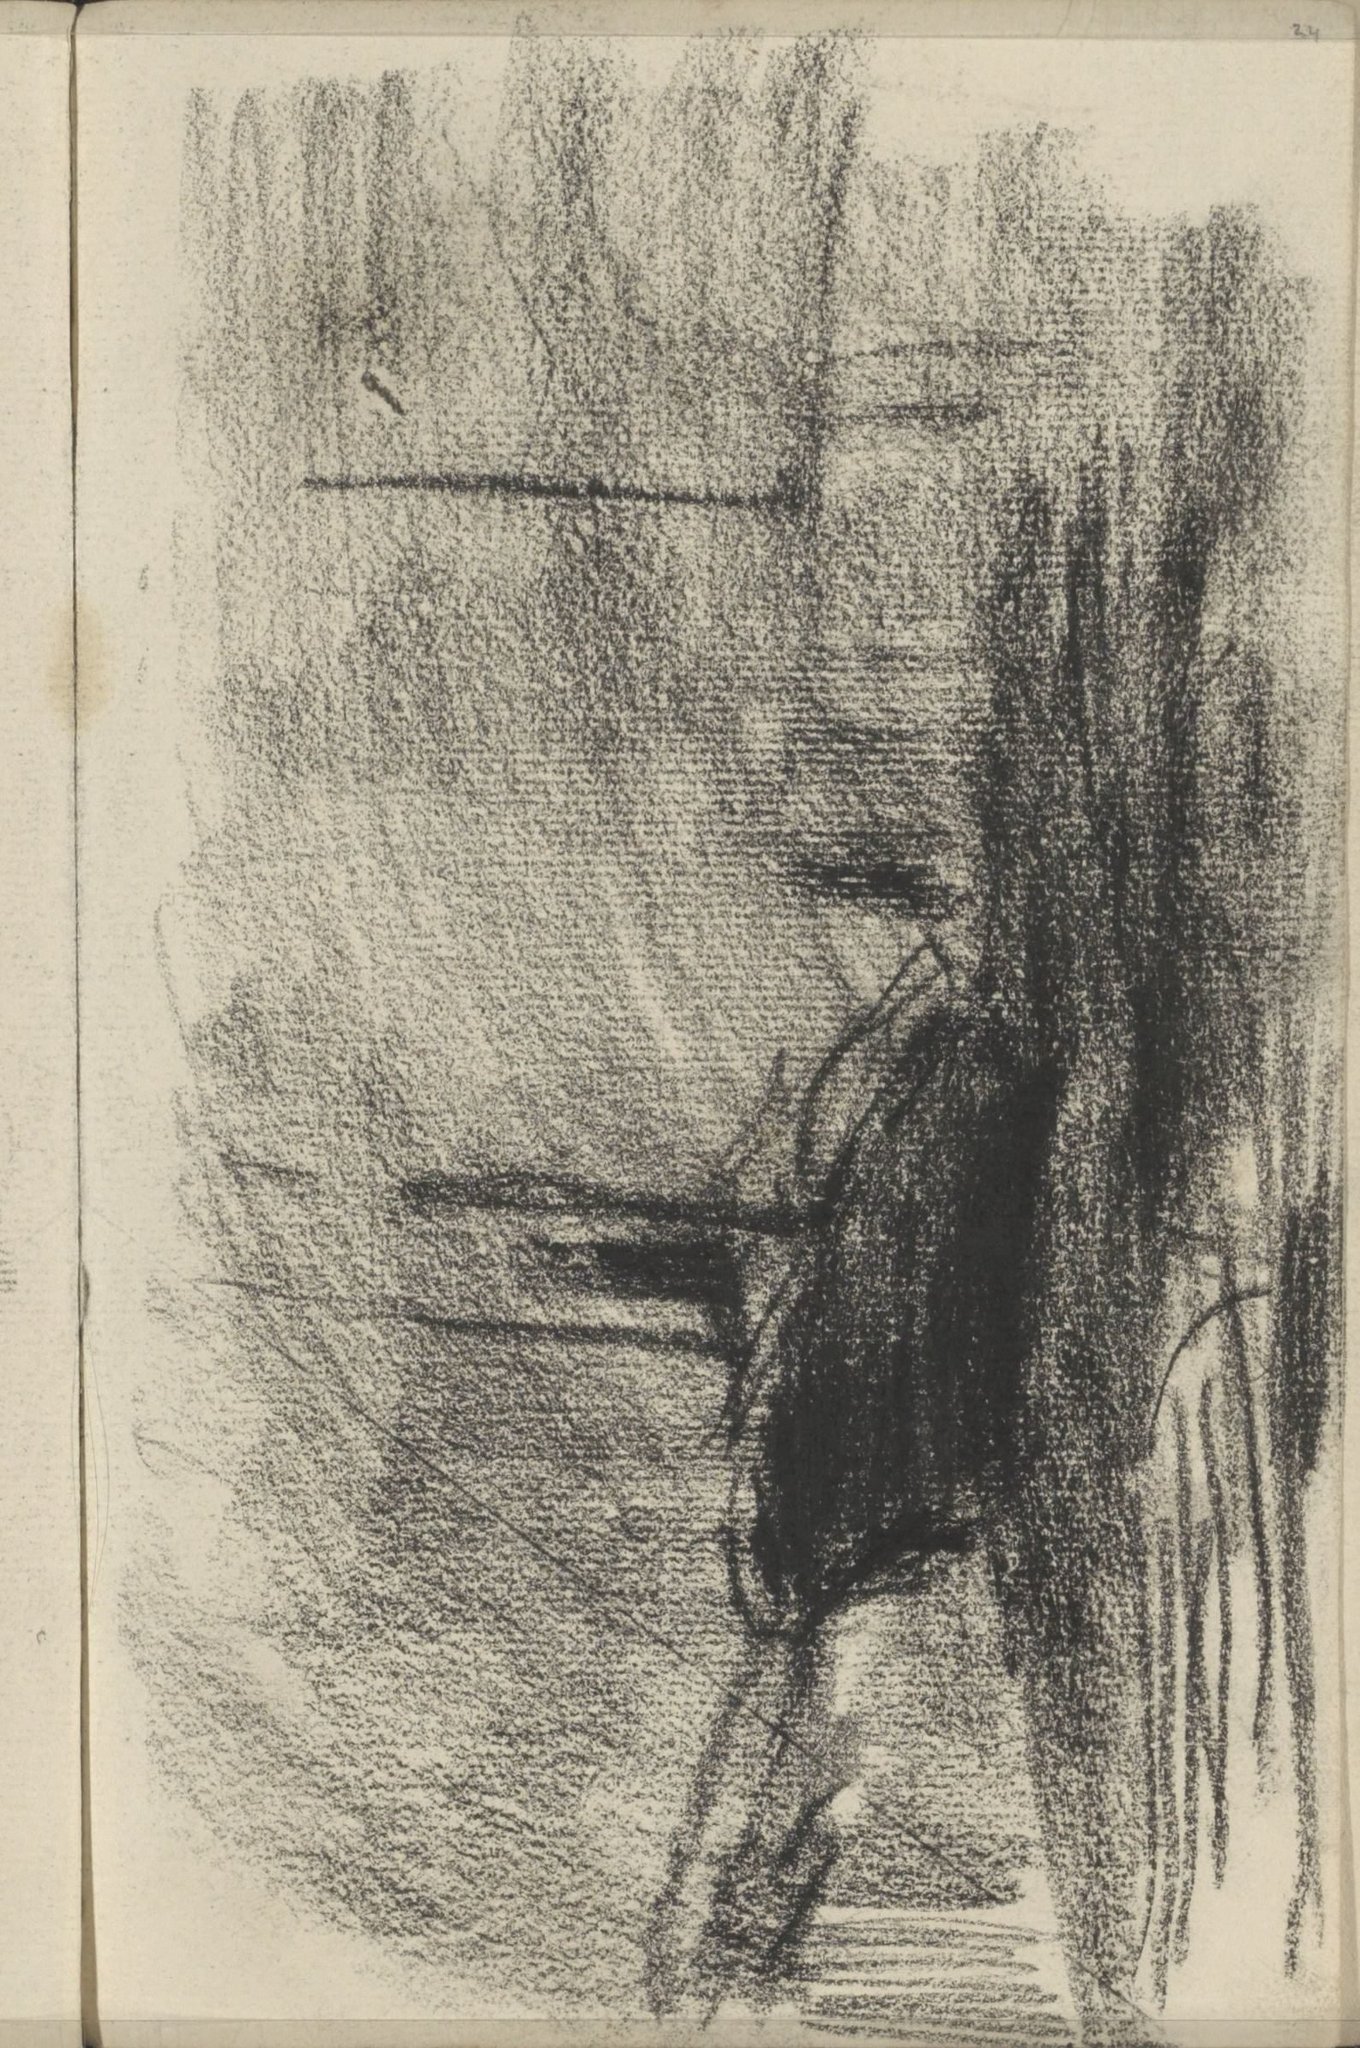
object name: sketchbook leaf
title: Schip bij een kade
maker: george hendrik breitner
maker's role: draughtsman, painter, print maker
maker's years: 1857-1923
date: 1886-1898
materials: chalk, paper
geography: amsterdam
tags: ships (in general), quay, amsterdam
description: Pagina 24 uit een schetsboek met 18 bladen.